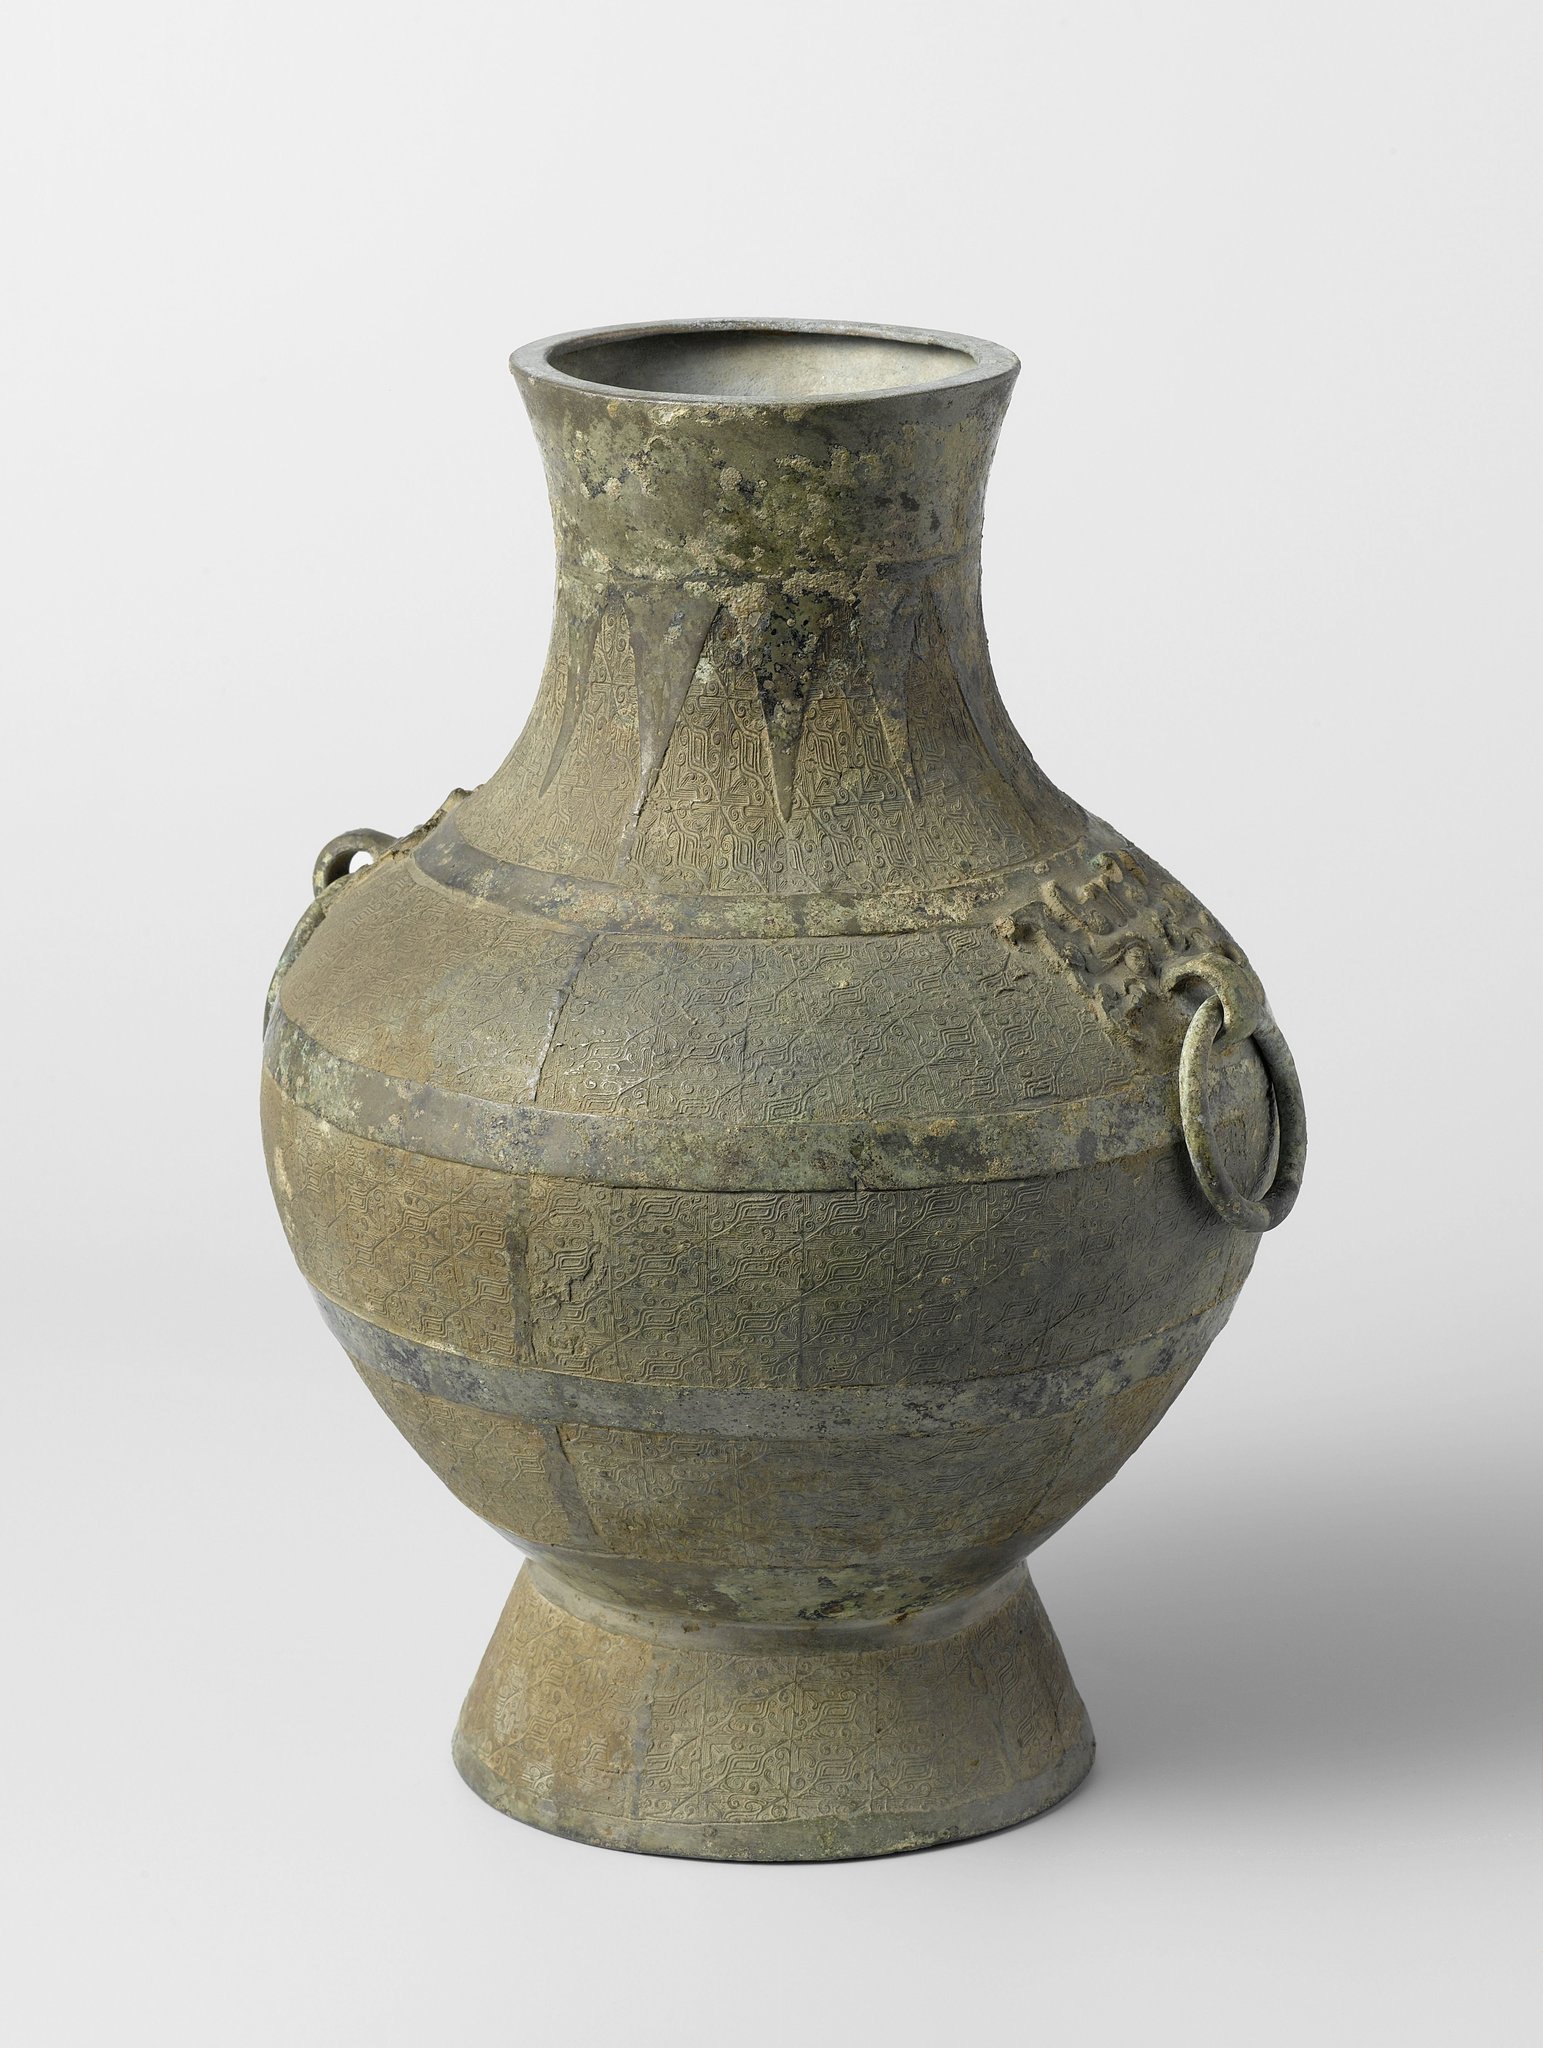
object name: hu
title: Ritual wine vessel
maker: Anonymous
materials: bronze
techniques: casting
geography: china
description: Vanaf 771 v.Chr. was China verdeeld in met elkaar strijdende staten. Met uiterlijk vertoon benadrukte iedere heerser zijn eigen macht: het brons uit deze zogenaamde periode van Strijdende Staten moest dus rijk versierd zijn. De mallen waarin het brons werd gegoten, werden met behulp van stempels voorzien van herhalende motieven. Zo konden makkelijk indrukwekkende series van identieke stukken worden gemaakt.